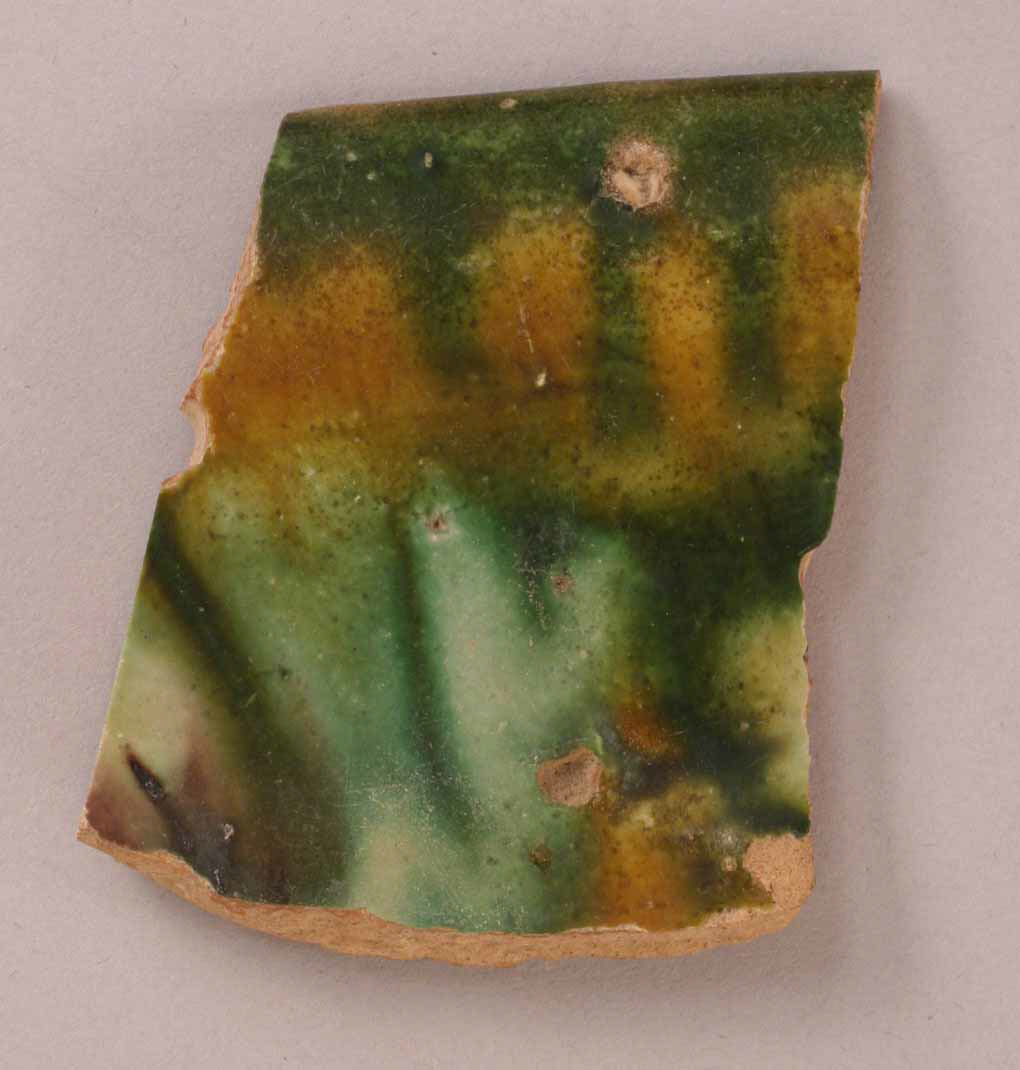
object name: fragment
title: Ceramic Fragment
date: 801-1000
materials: earthenware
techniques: glazing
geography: iraq